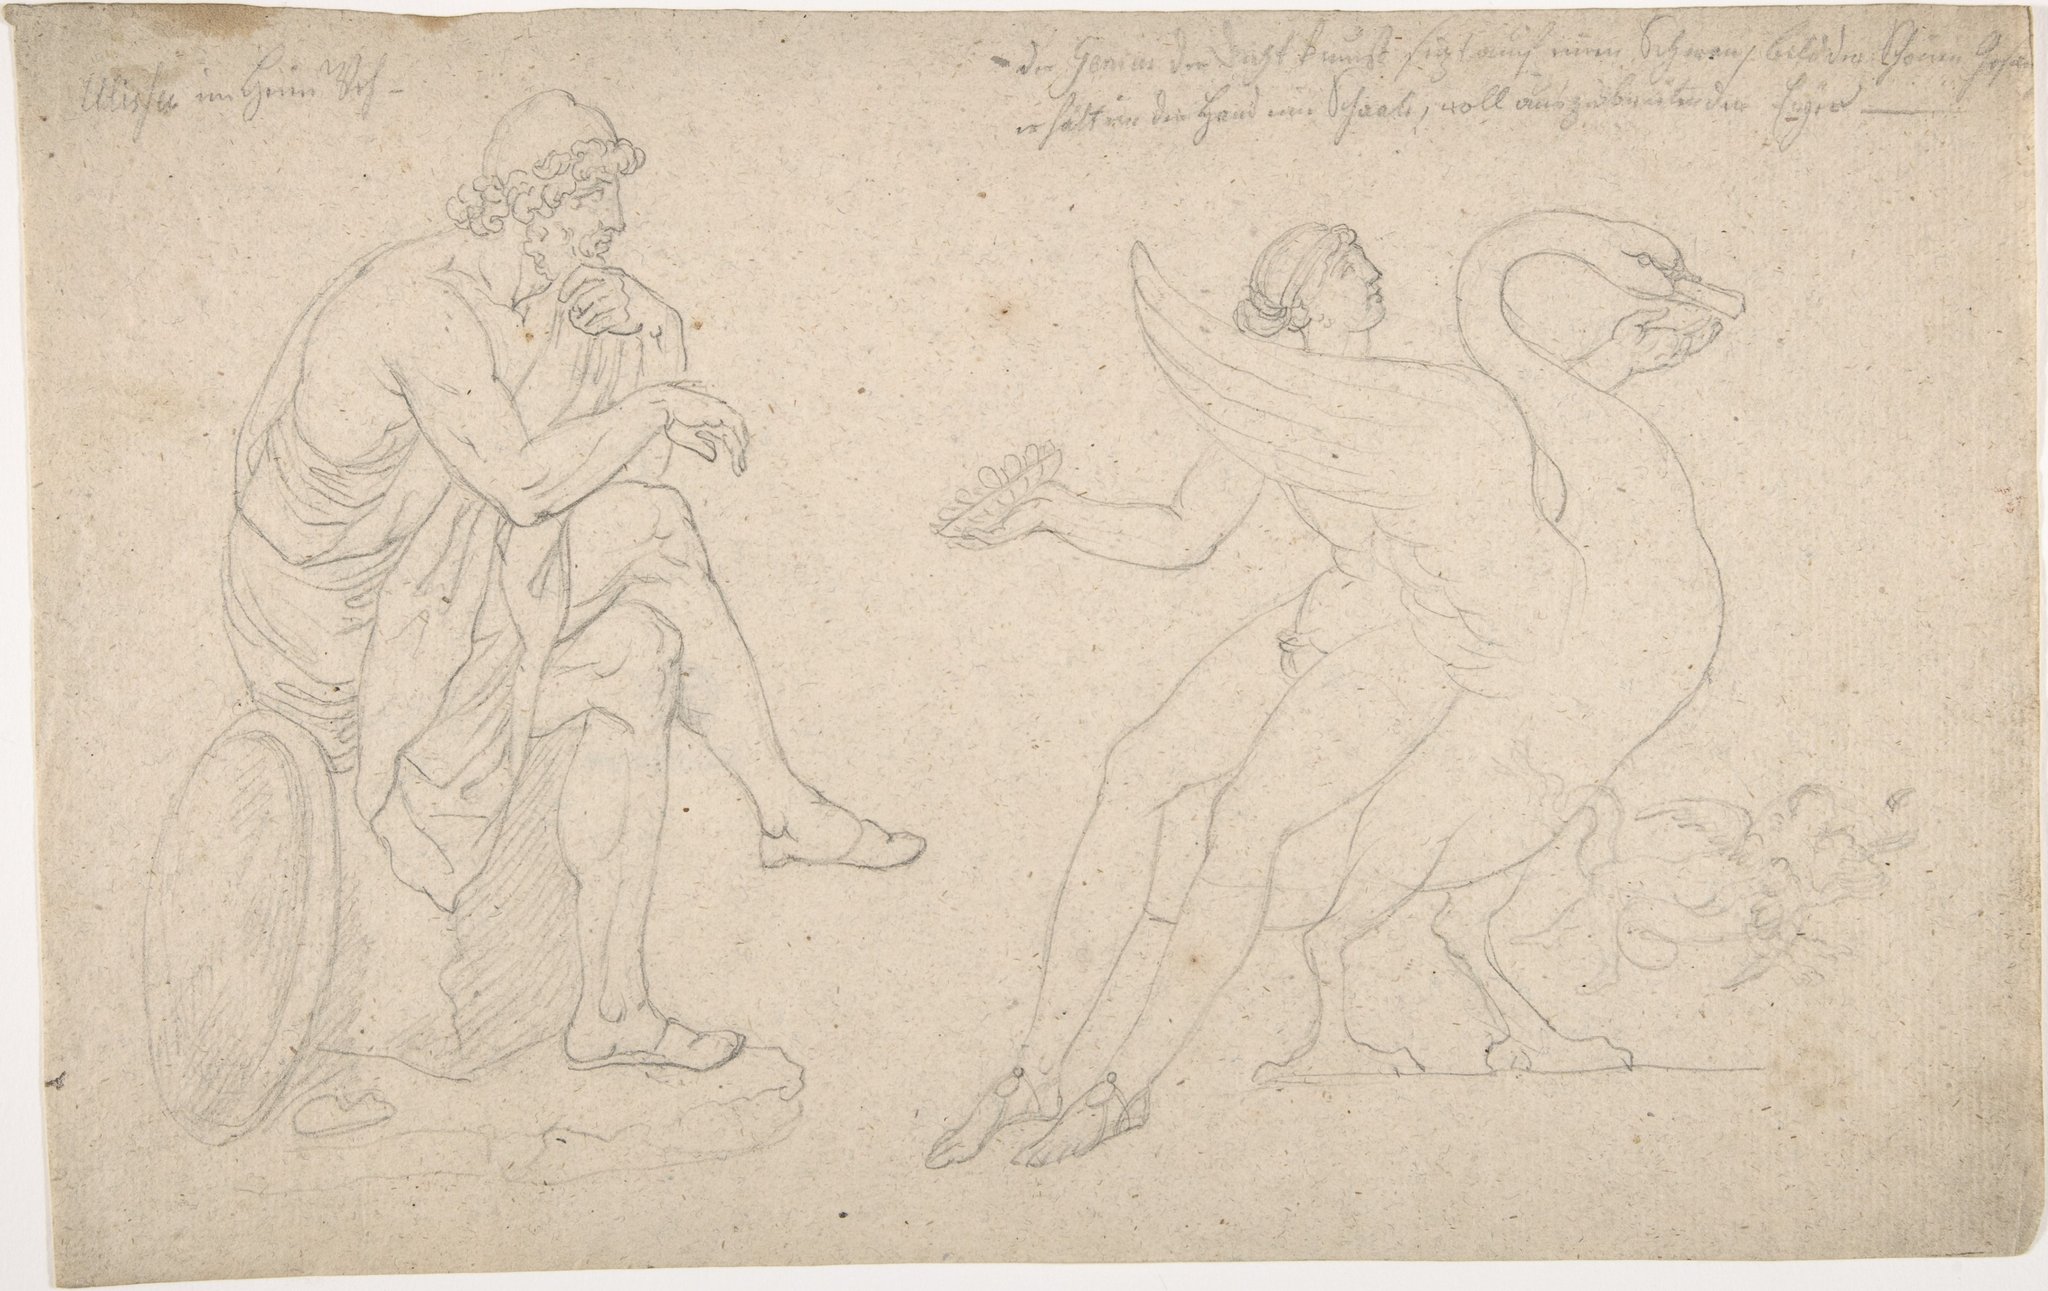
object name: drawing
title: Ornament with Mythic Figures: Ulysses, a youth seated on a swan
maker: anonymous, german, 19th century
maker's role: artist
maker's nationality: german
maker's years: 1800-1899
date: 1780-1820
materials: graphite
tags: female nudes,swans